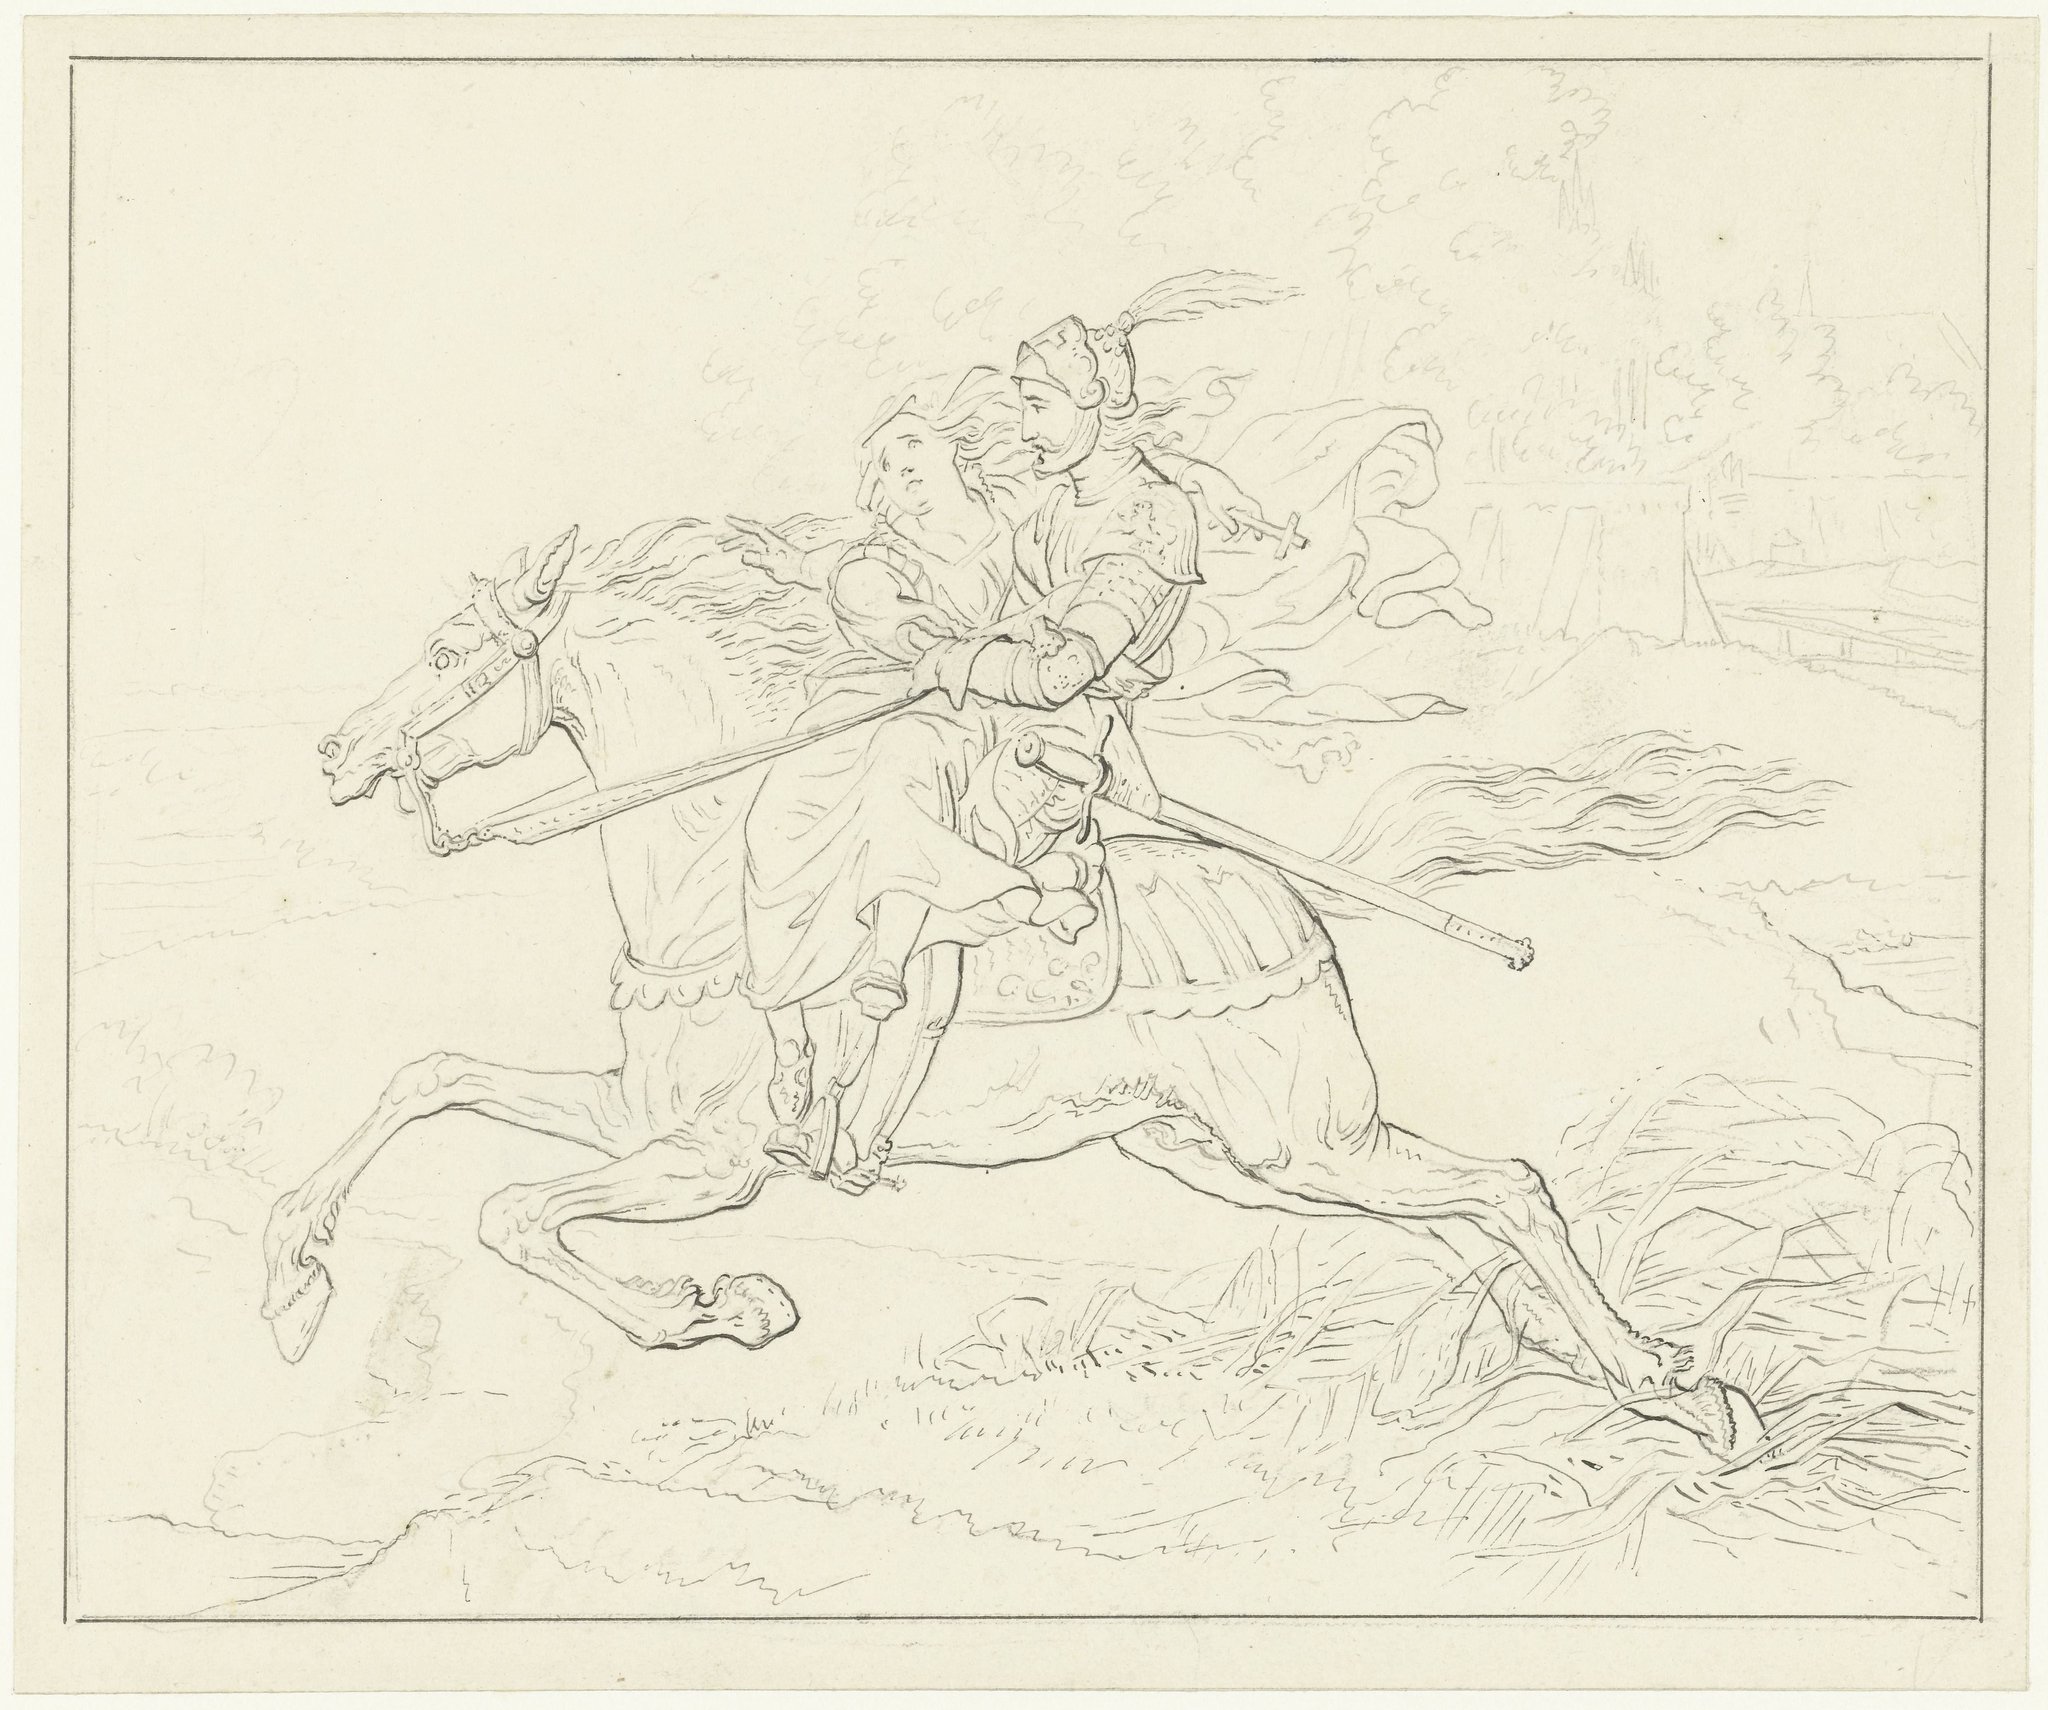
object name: drawing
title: Ridder met een vrouw te paard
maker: louis moritz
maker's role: draughtsman, painter, print maker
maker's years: 1773-1850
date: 1773-1850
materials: ink, paper, pencil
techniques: pen